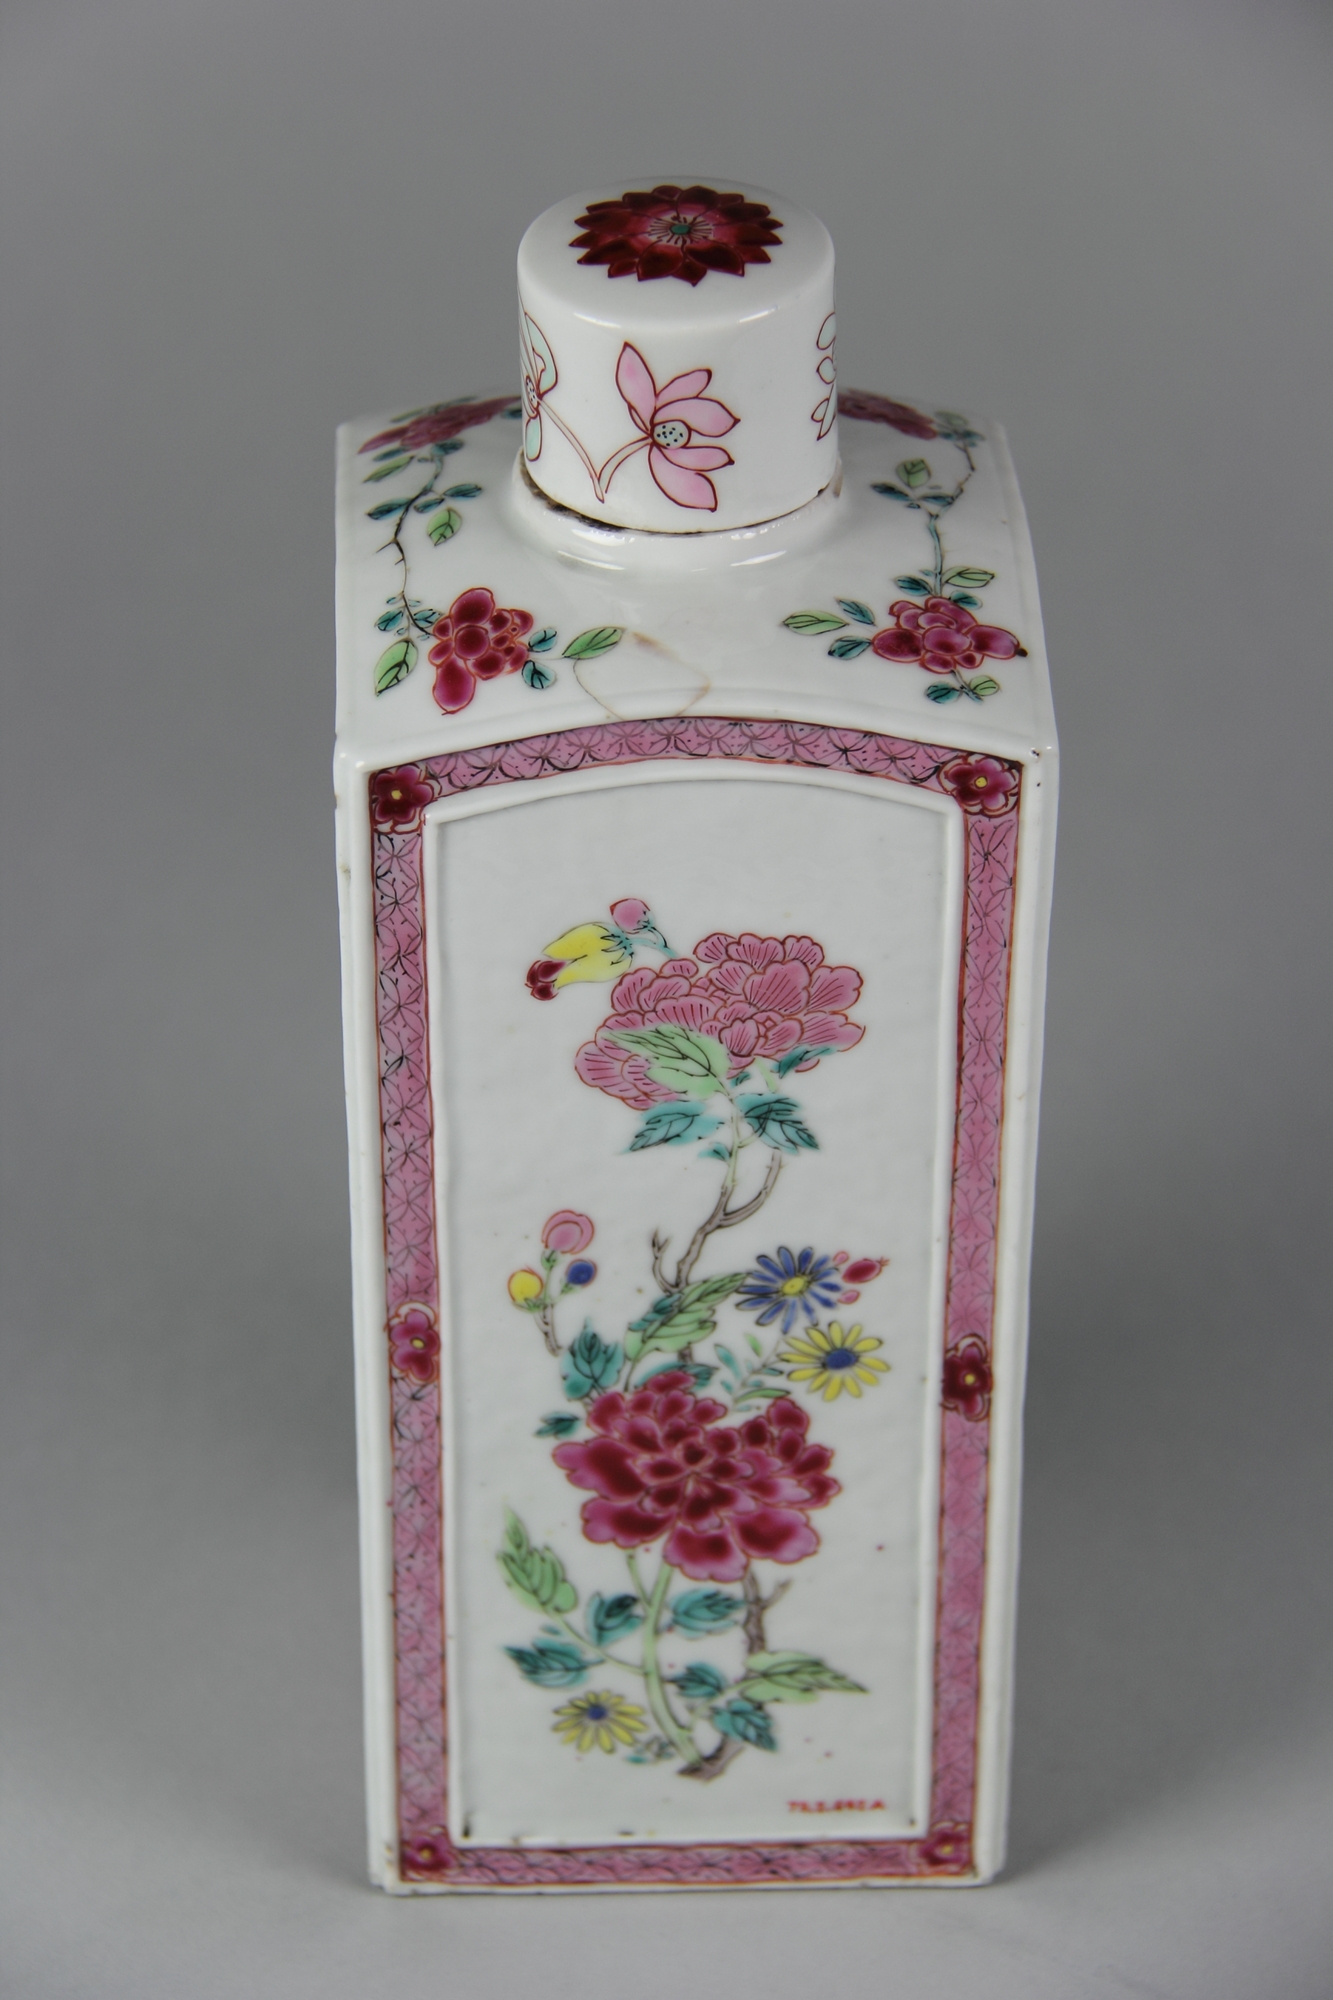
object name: bottle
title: Covered square bottle with flowers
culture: chinese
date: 1767-1800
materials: enamel, porcelain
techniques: overglaze, painting, polychrome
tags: flowers